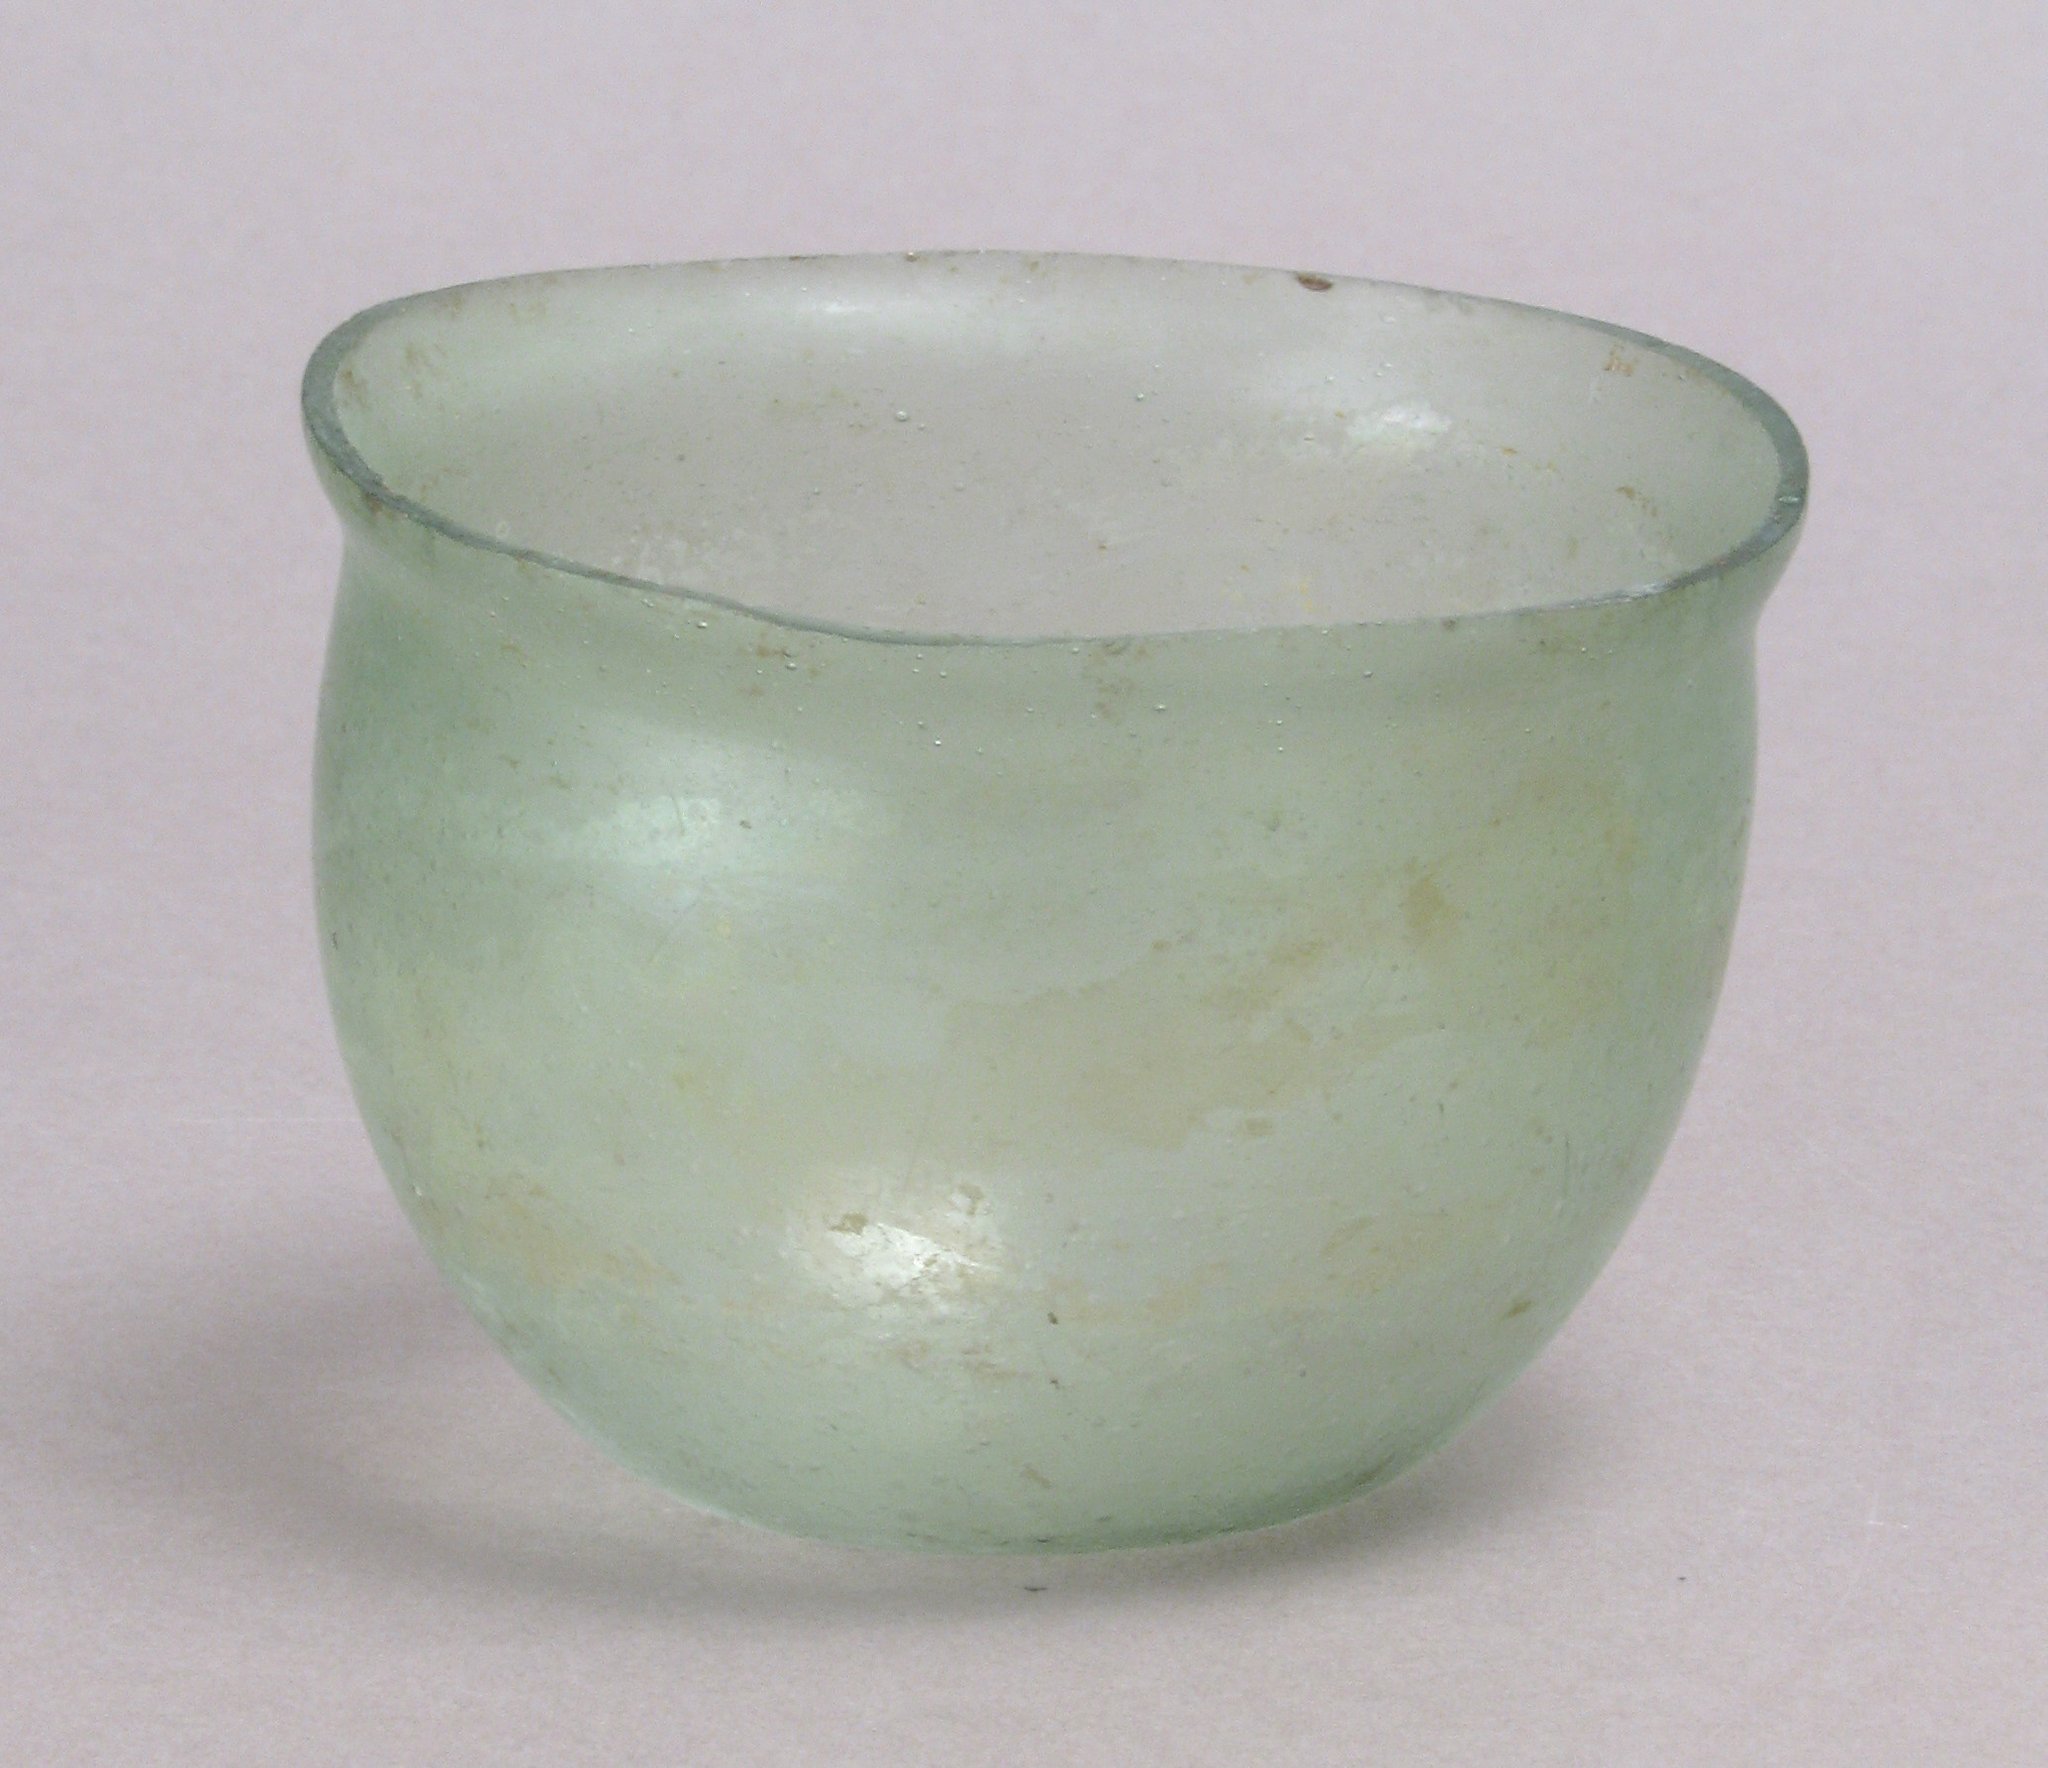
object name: bowl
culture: roman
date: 367-433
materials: glass